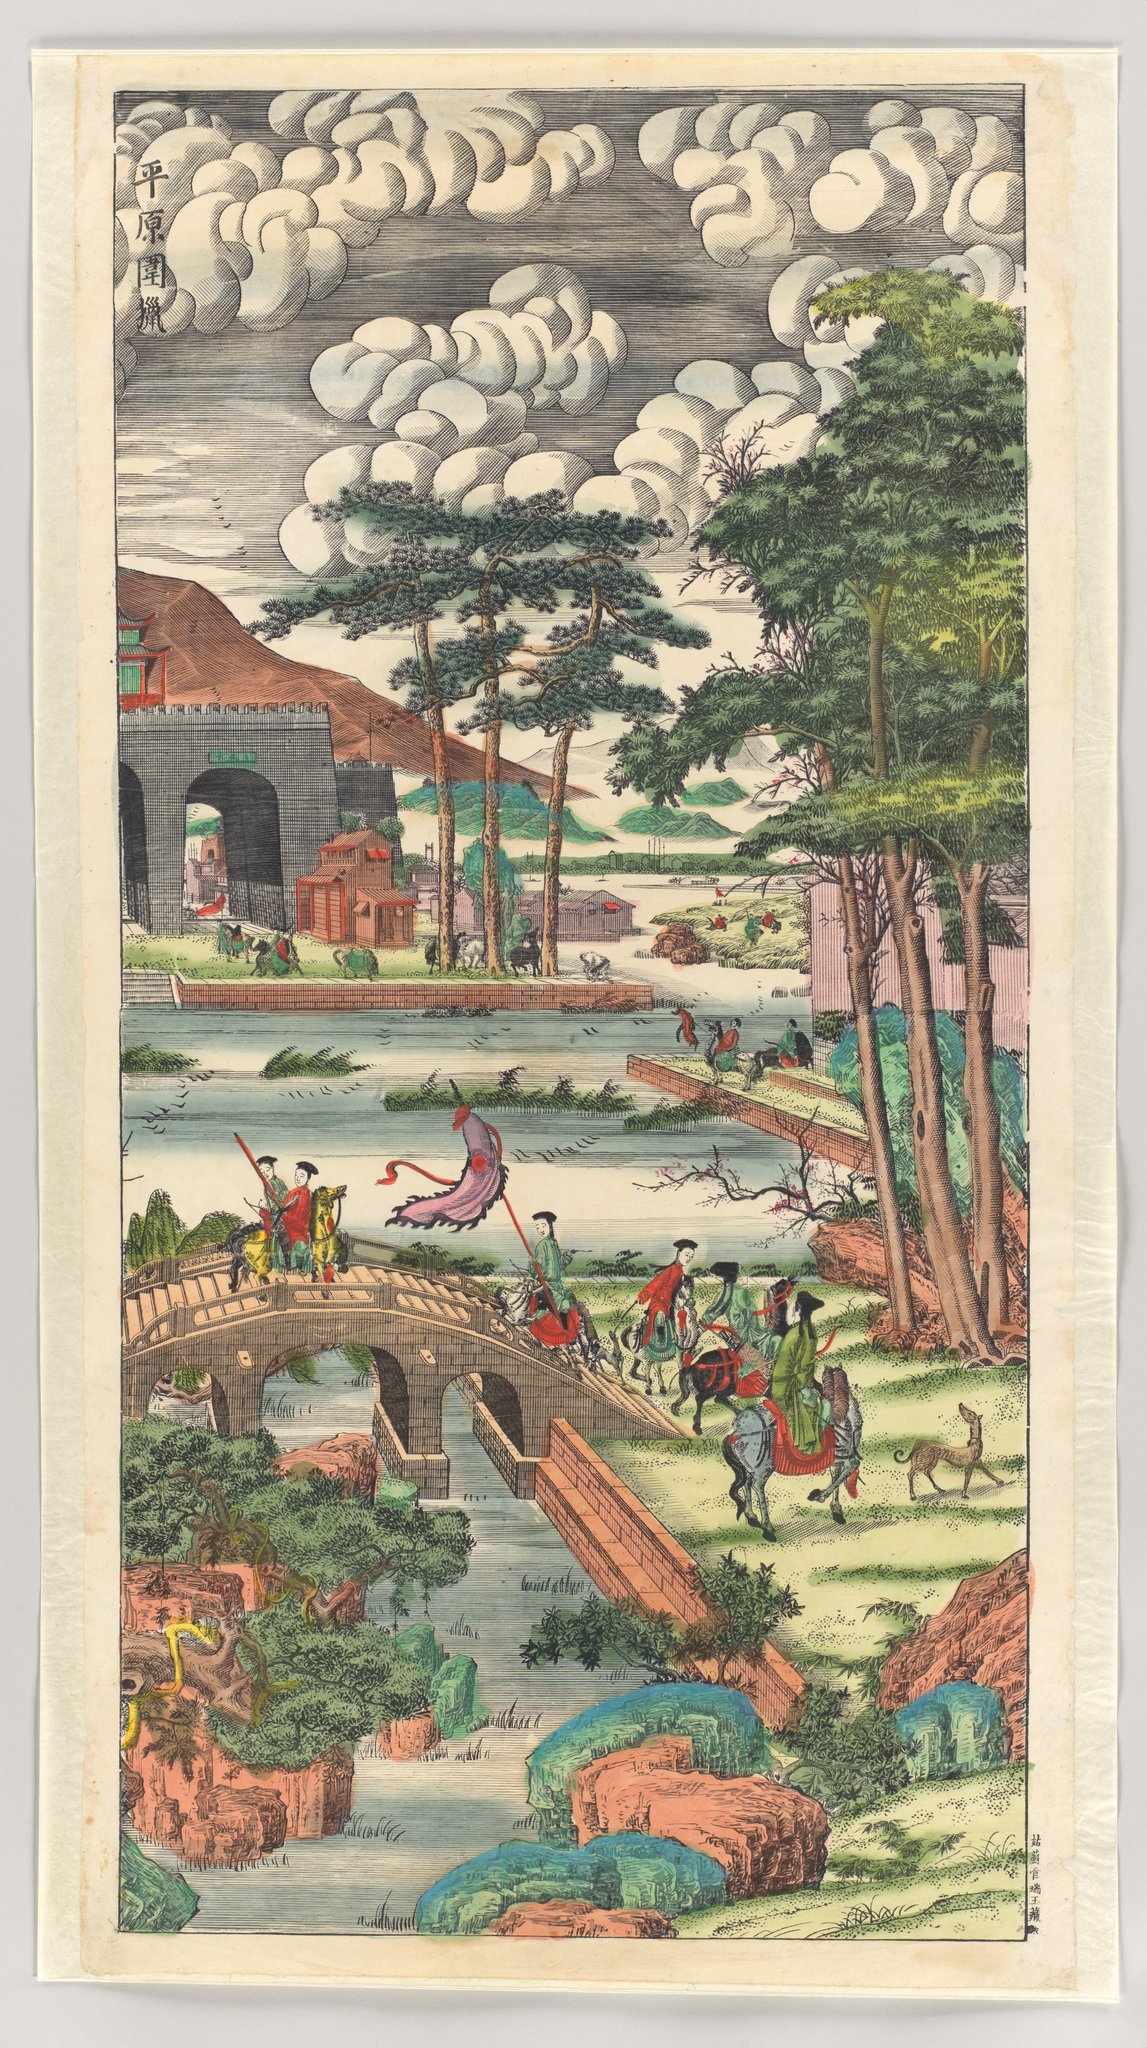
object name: print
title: A Hunt on the Plains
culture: chinese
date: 1701-1800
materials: ink, paper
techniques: hand coloring, woodblock print